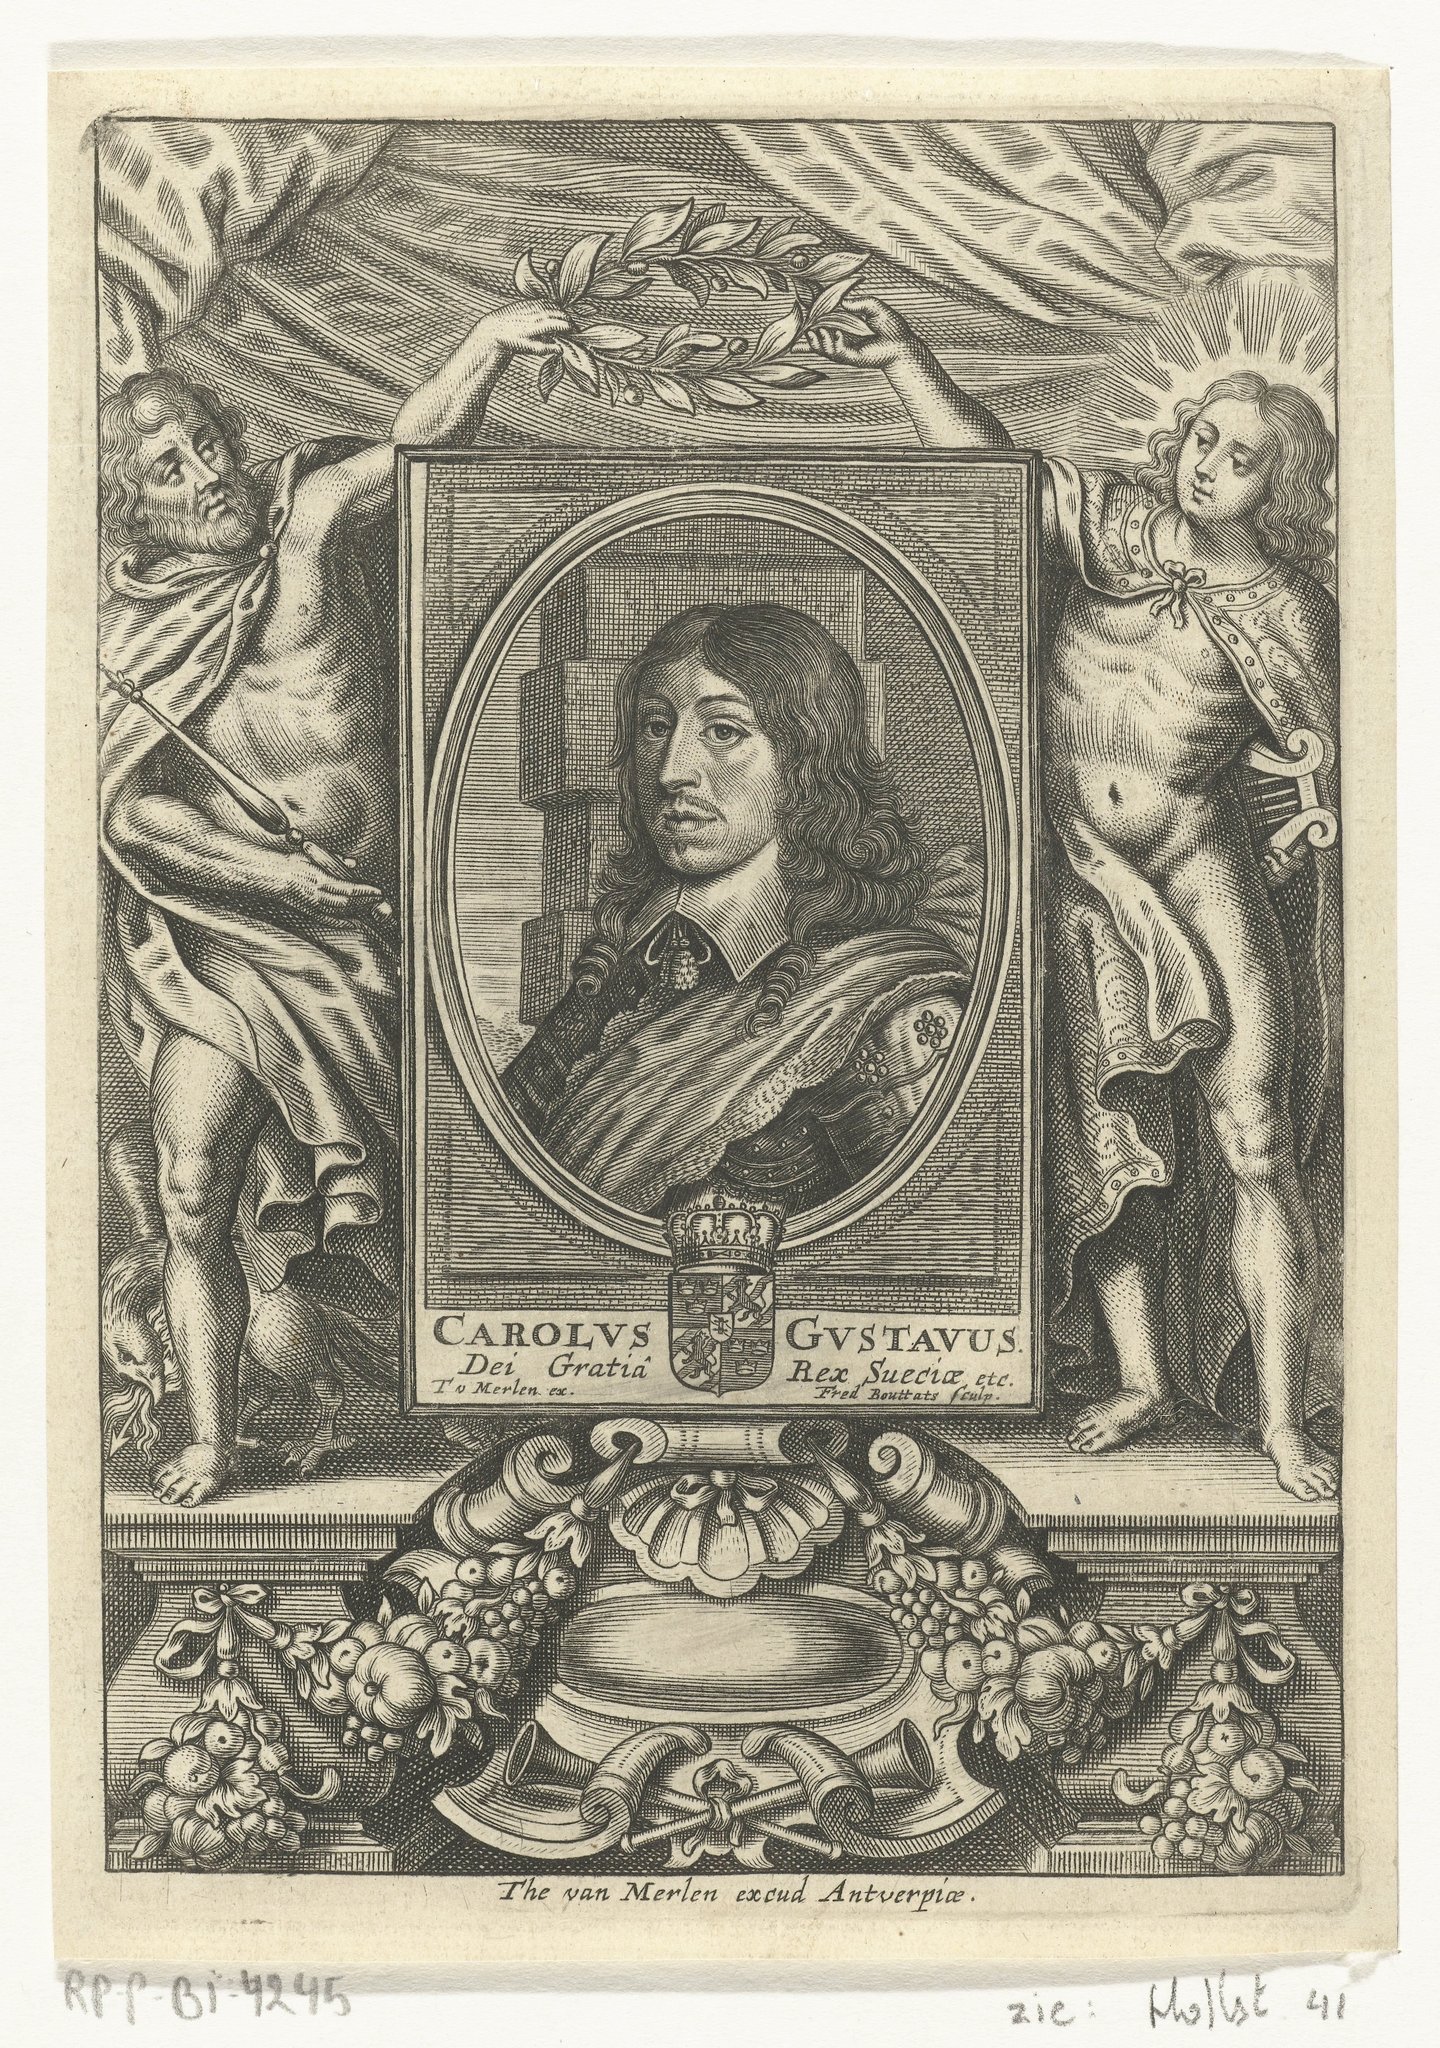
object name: print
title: Carolvs Gvstavus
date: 1654-1676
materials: paper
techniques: engraving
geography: antwerp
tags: (story of) apollo (phoebus), (story of) jupiter (zeus)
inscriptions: collector's mark: Lugt 2228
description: Portret in een ovale lijst van Karel X Gustaaf, koning van Zweden. Buste naar links. Karel Gustaaf draagt een harnas en wordt geflankeerd door Jupiter (l.) en Apollo (r), die een lauwerkrans ophouden. De prent heeft een Latijns onderschrift met de naam van de geportretteerde.